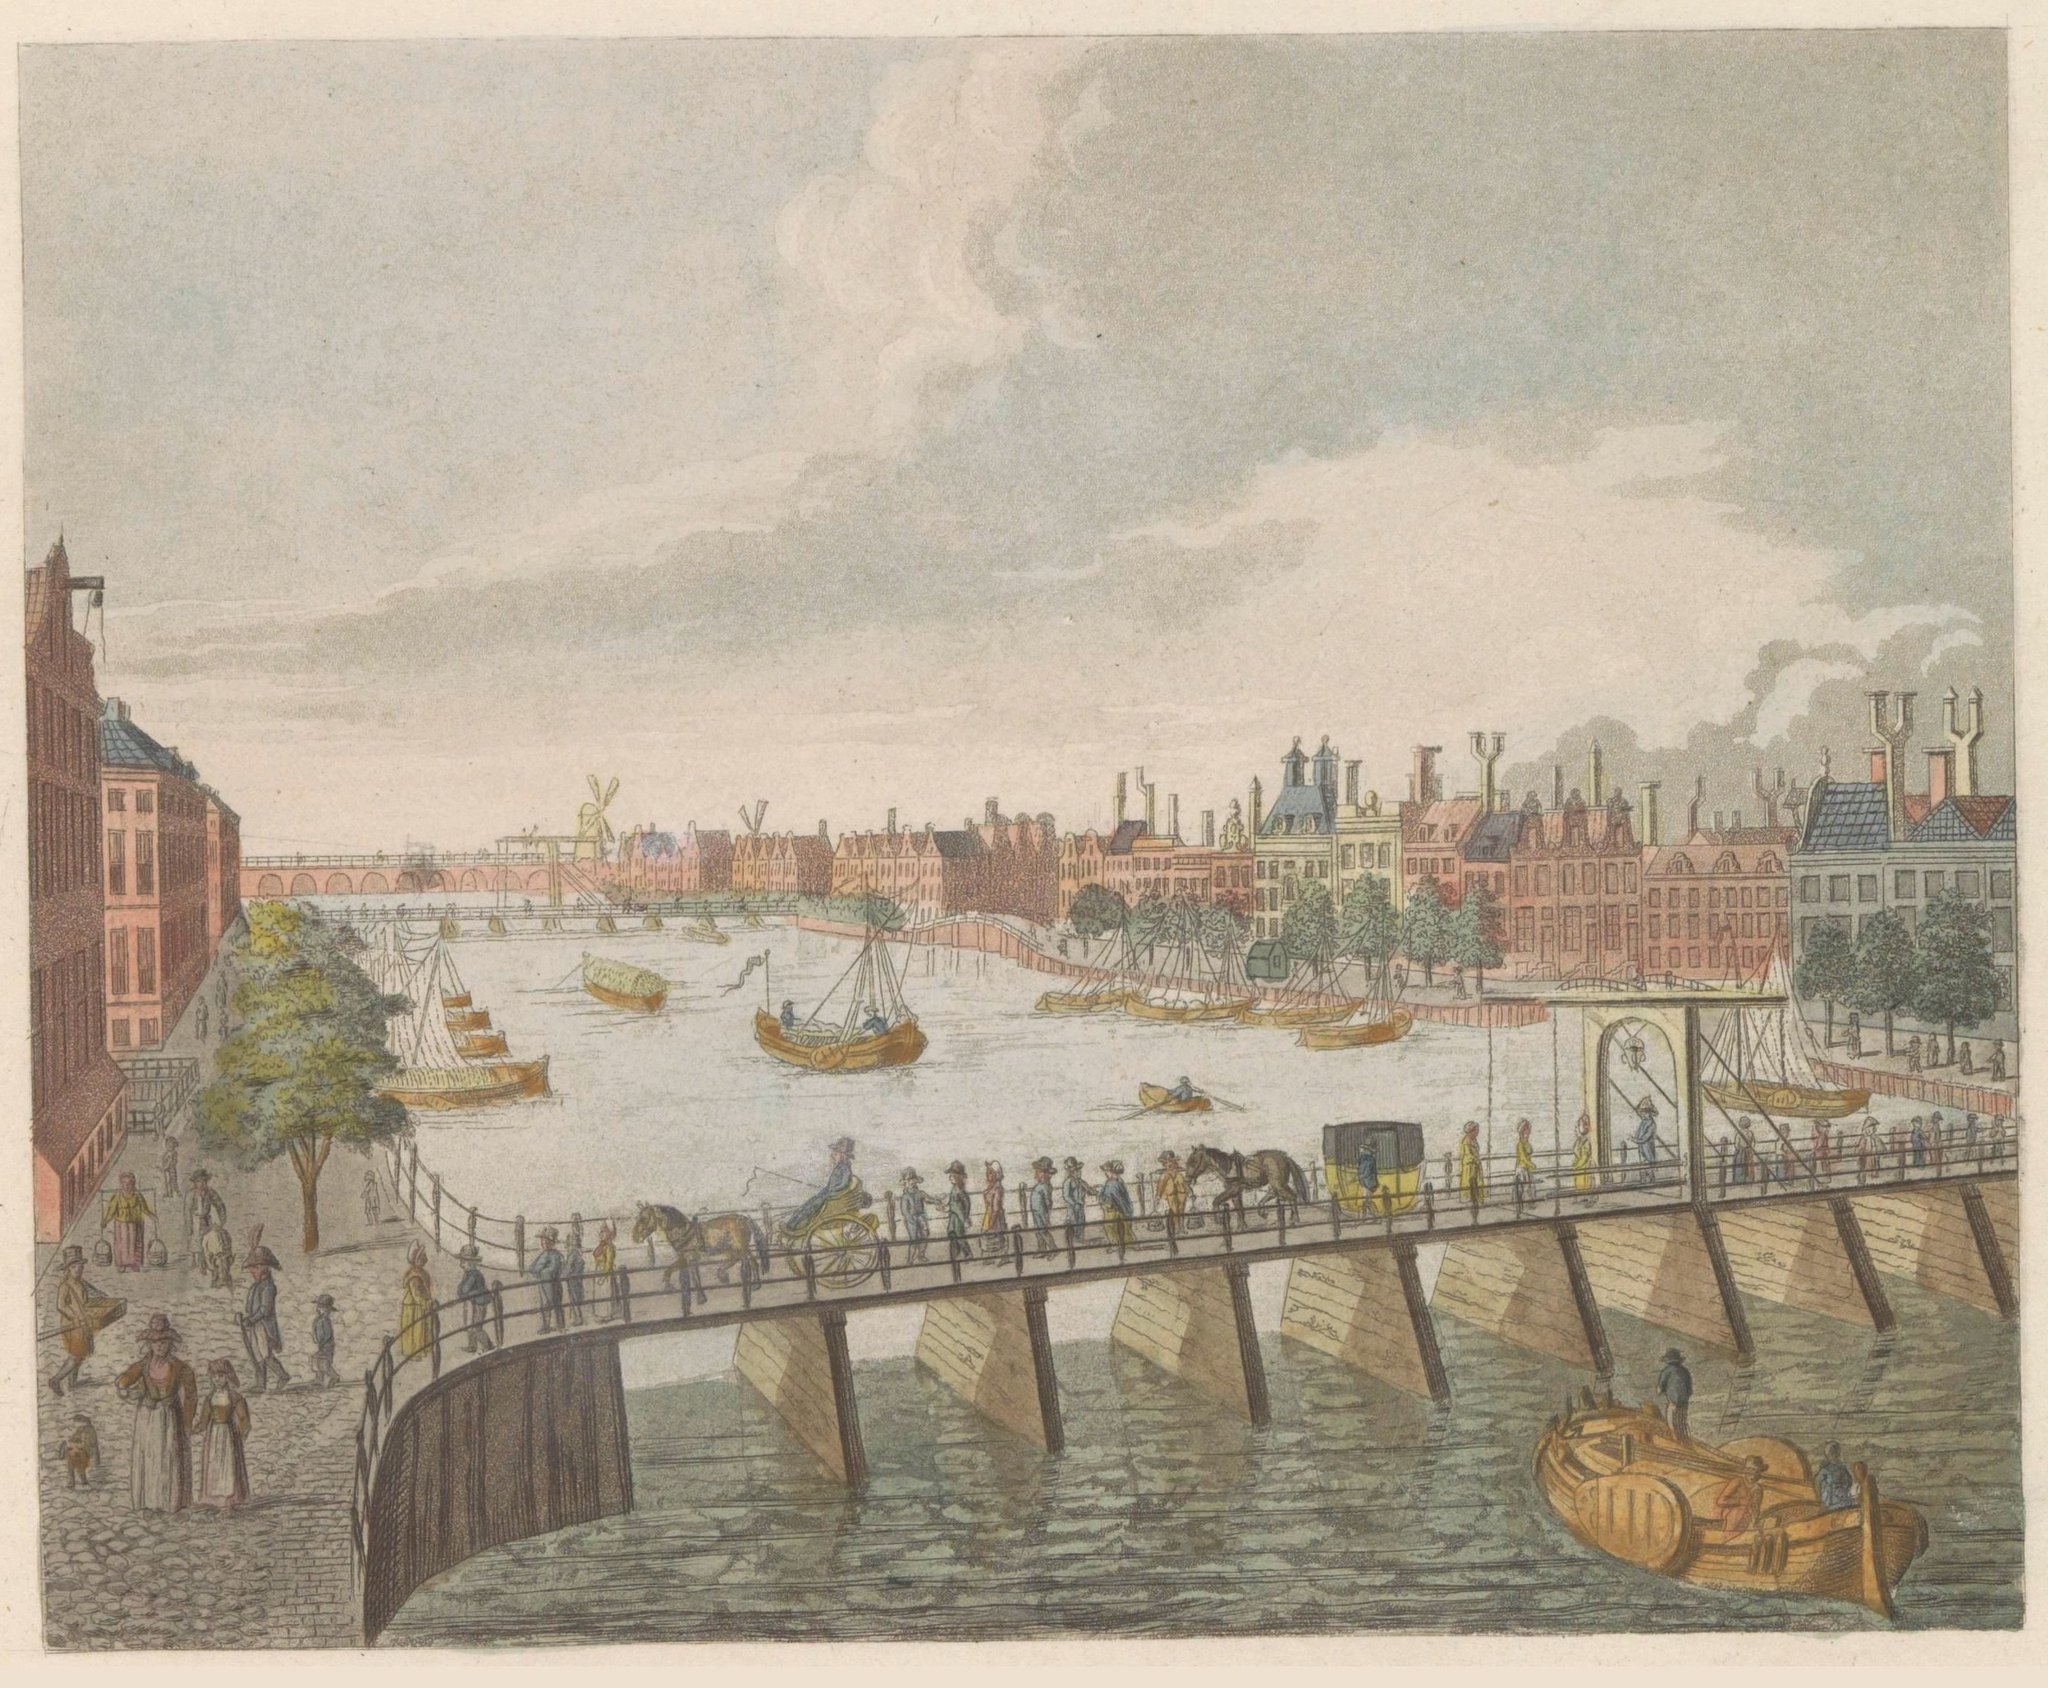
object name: print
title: Vue de l'Amstel interieur, prise du Blaauwe-Brug jusqu'a l'Hooge-Sluys ou Pont des Amoureux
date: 1810-1813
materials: paper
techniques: aquatint, engraving, etching, hand coloring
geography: amsterdam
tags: blauwbrug, hogesluis, magere brug, binnen-amstel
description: De Binnen-Amstel, gezien naar het zuiden in de richting van de Hogesluis, te Amsterdam, ca. 1810-1813. Op de voorgrond de Blauwbrug, daarachter de Magere Brug. Onderdeel van een plaatwerk uit ca. 1824-1825 met 74 (ongenummerde) platen van de belangrijkste topografische gezichten en verschillende zeden en gewoonten in het Verenigd Koninkrijk der Nederlanden.